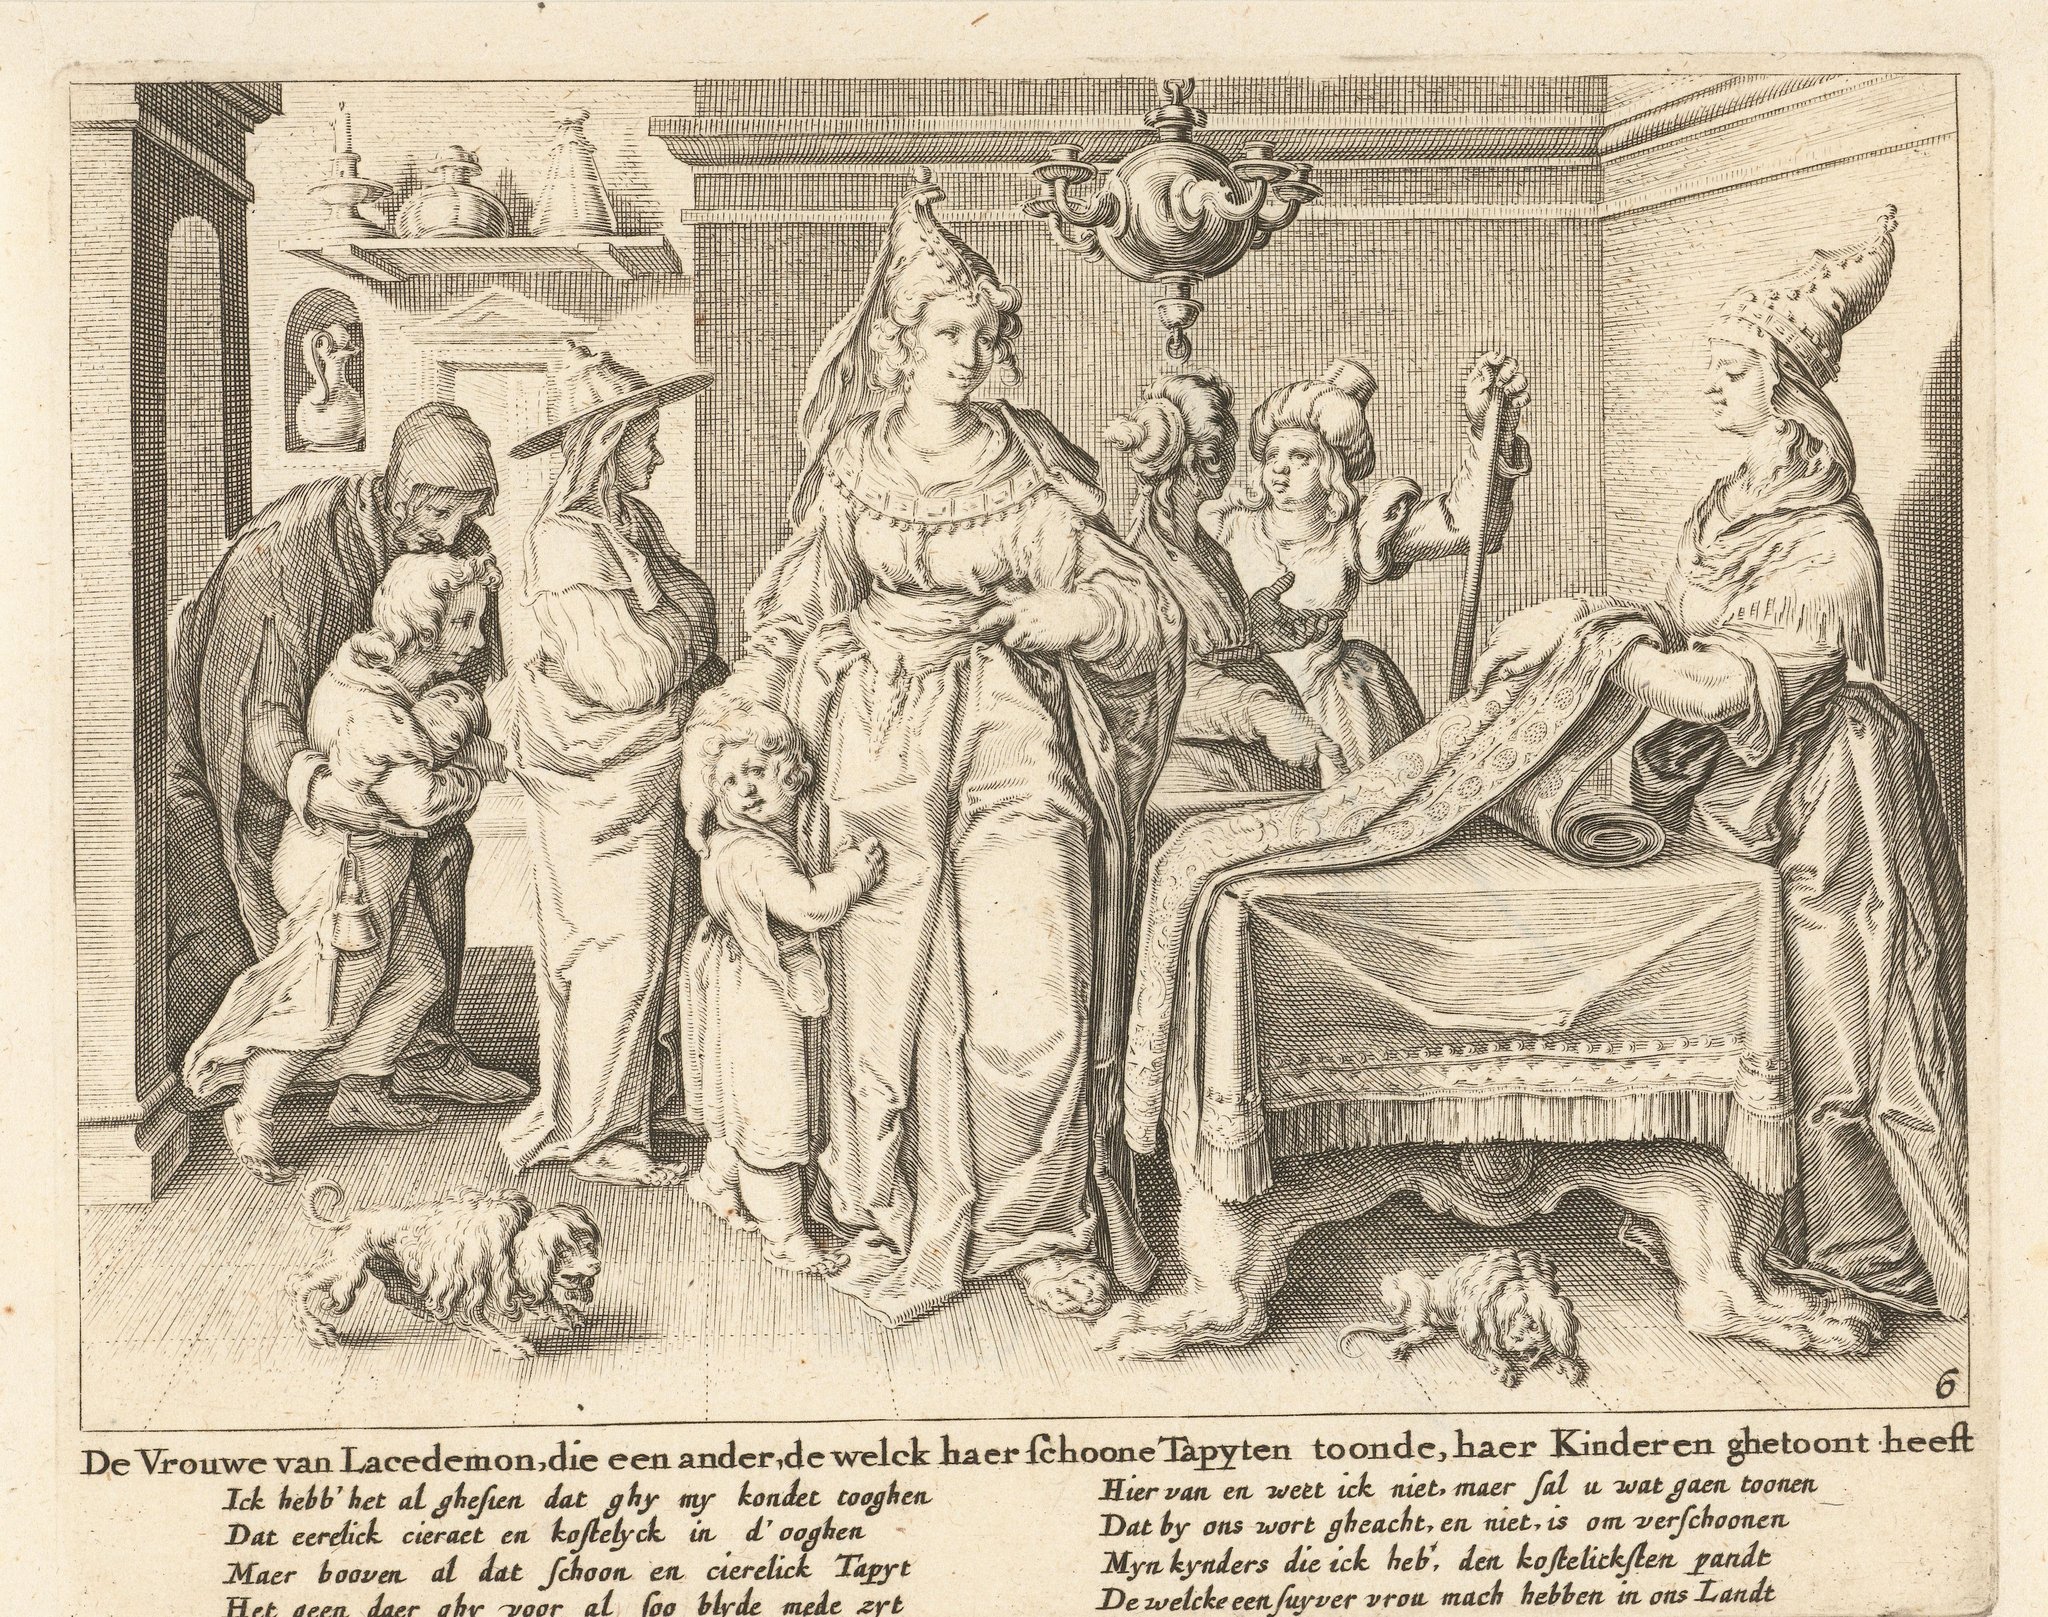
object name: print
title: Een vrouw uit Lacedemon toont haar kinderen aan een tapijtenweefster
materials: paper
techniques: engraving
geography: leiden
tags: mother and child(ren), woman and child(ren) (family group), tapestry weaver, gobelin maker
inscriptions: collector's mark: Lugt 2228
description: Een vrouw afkomstig uit Lacedemon komt bij een tapijtenweefster die haar de mooiste tapijten toont. De vrouw toont de tapijtenweefster wederom het mooiste wat zij bezit, haar kinderen. In de verkoopruimte zijn nog andere klanten aanwezig. Twee vrouwen praten met elkaar en een man helpt een jongetje naar binnen.